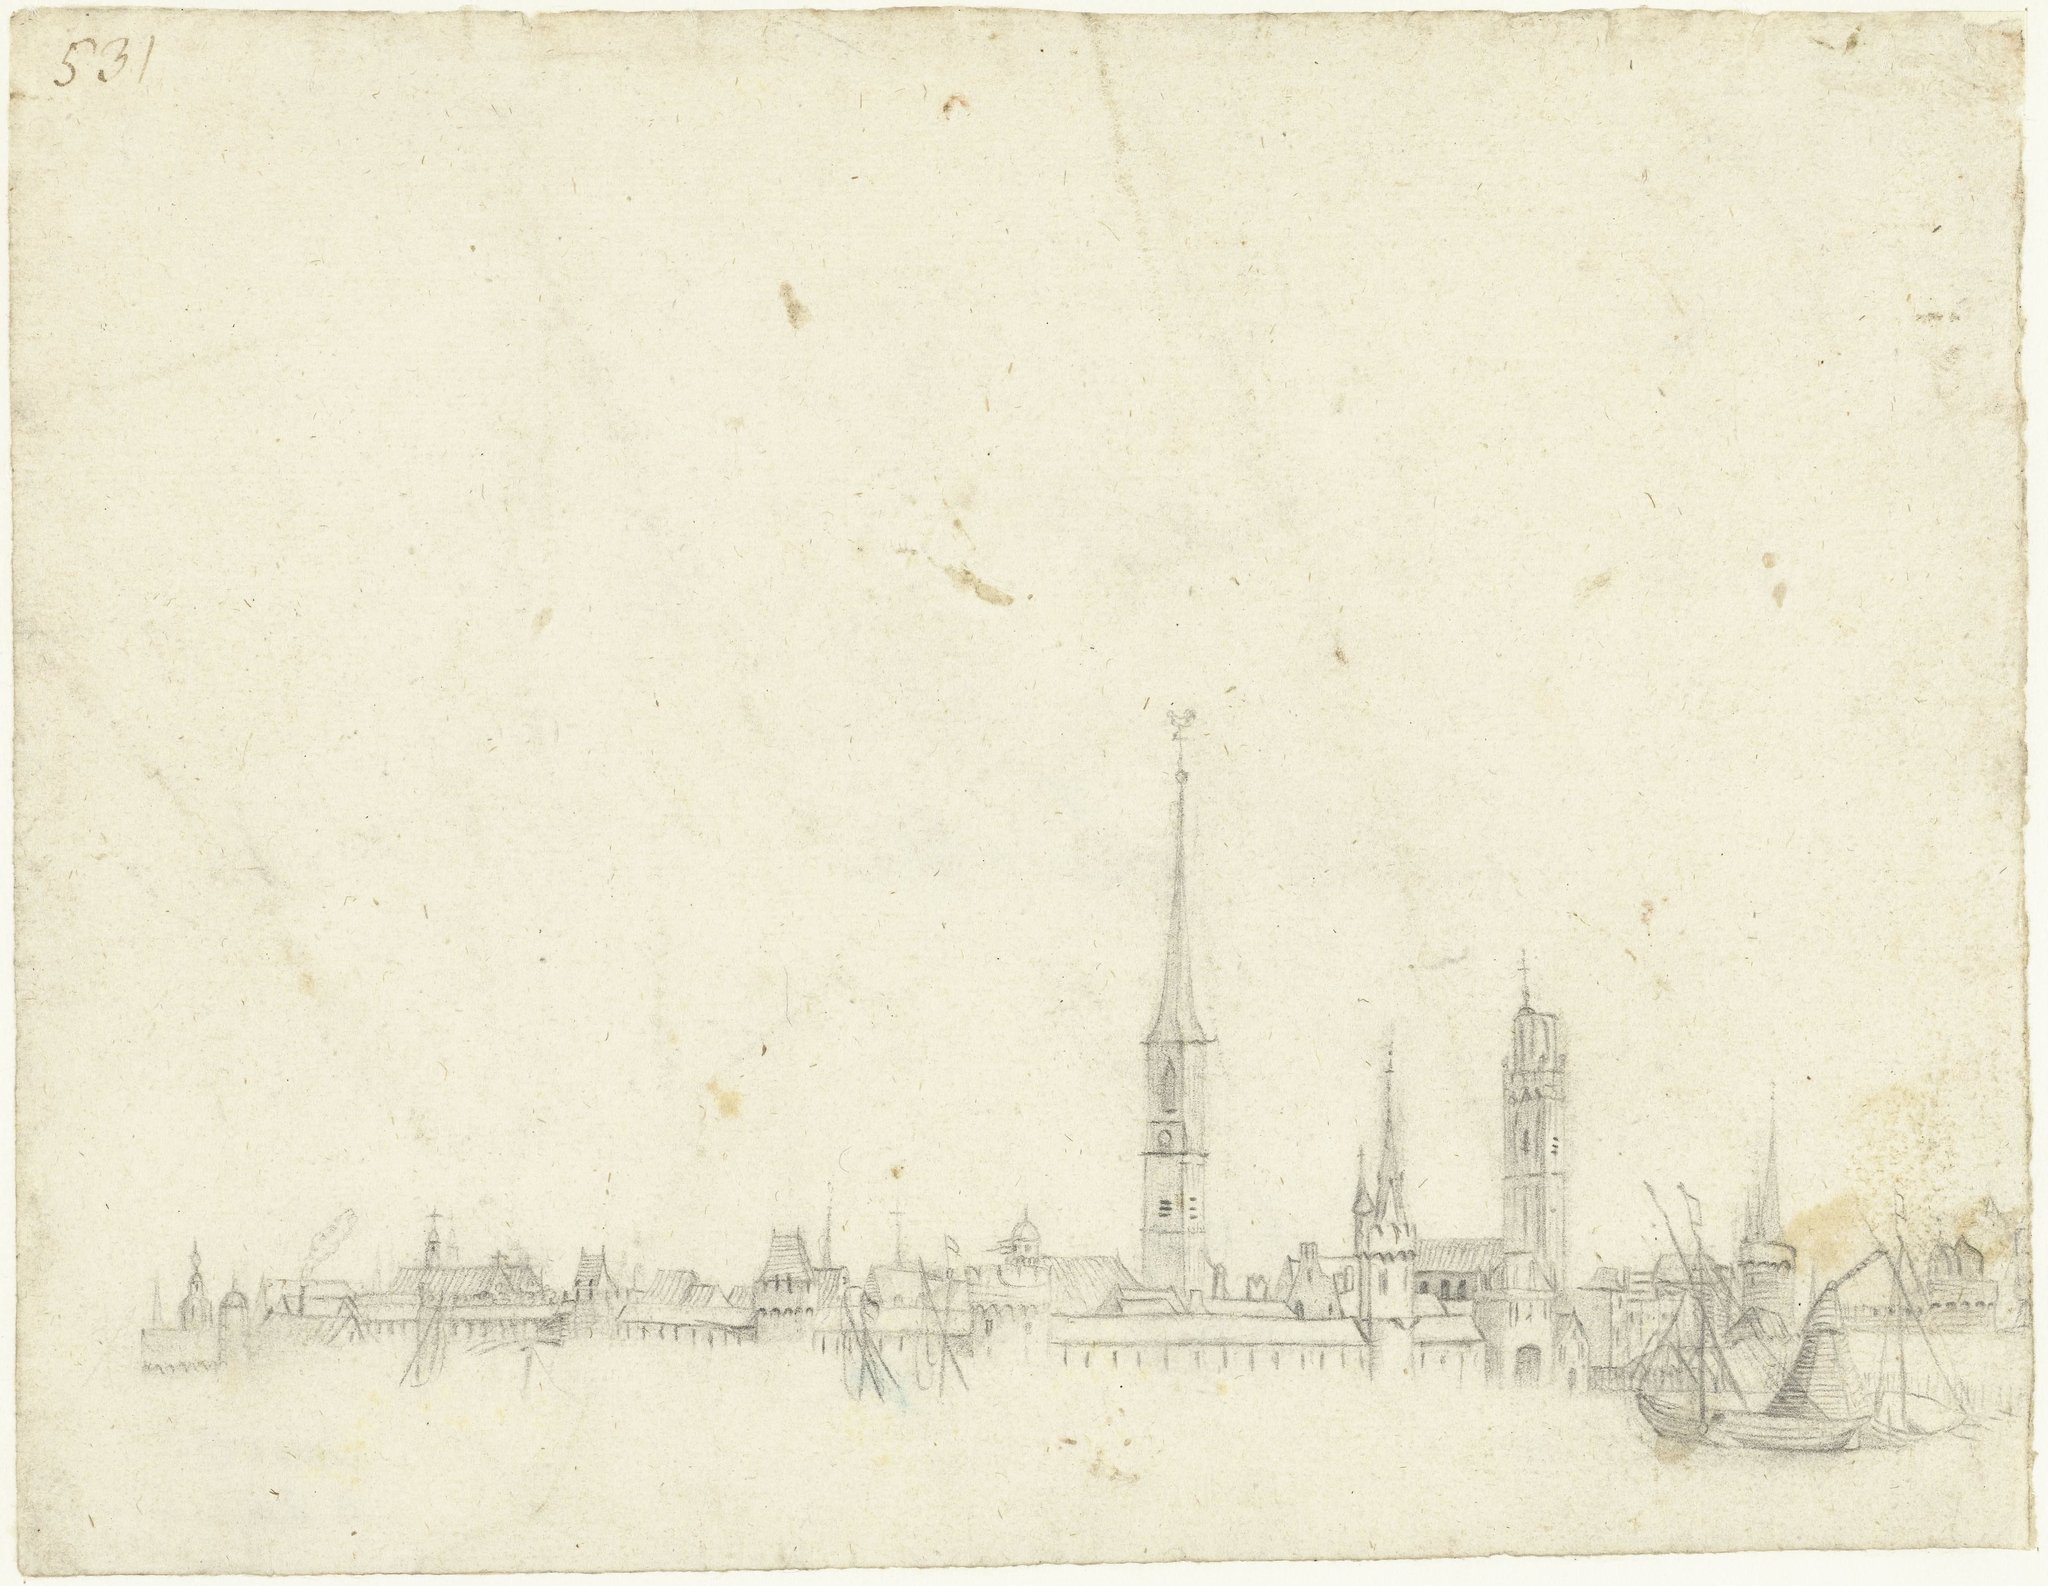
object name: drawing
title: Gezicht op Zwolle, vanuit het noorden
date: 1647-1657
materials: paper, pencil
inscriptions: annotation: ‘Zwolle’